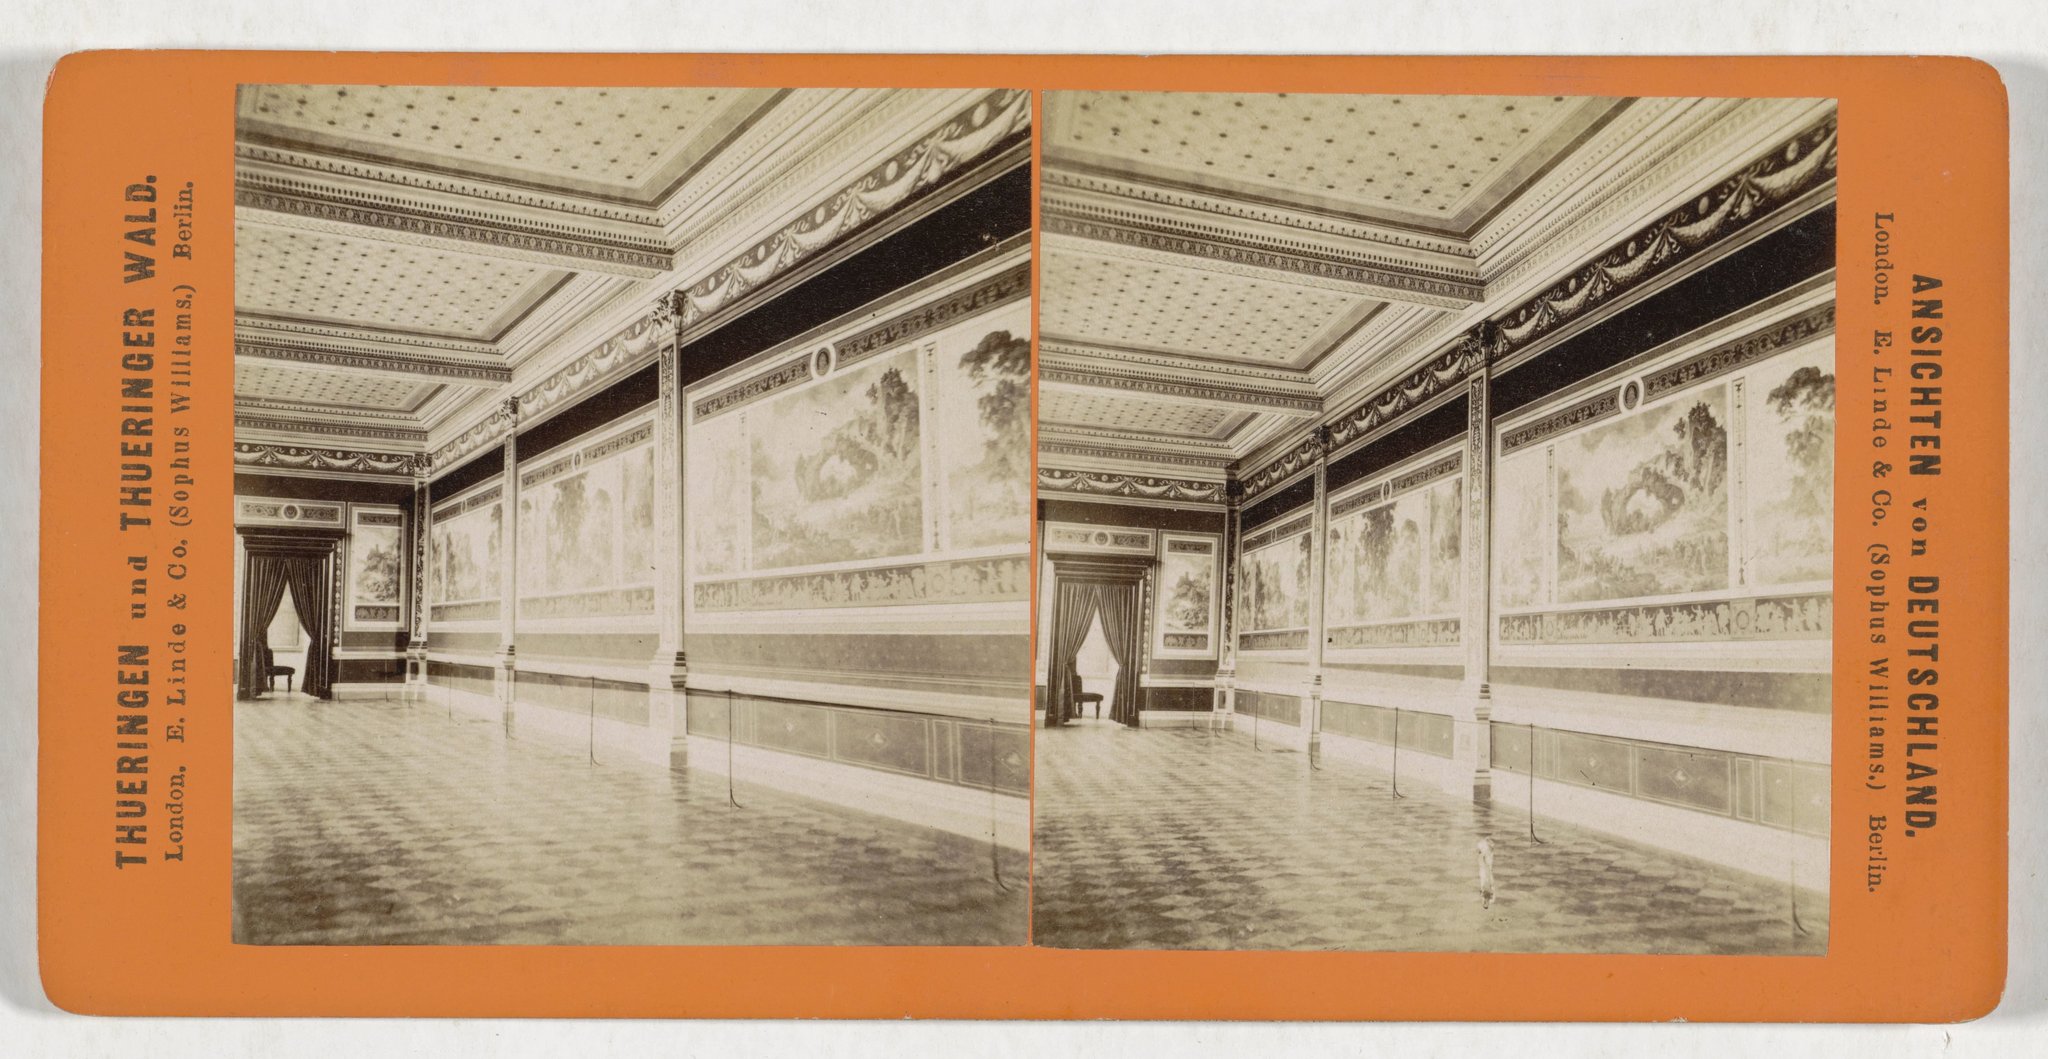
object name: stereograph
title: Prellergalerij in het Neues Museum Weimar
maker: hermann selle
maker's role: fotograaf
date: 1868-1890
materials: cardboard, paper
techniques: albumen print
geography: weimar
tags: museum personnel, gallery (spacious corridor)